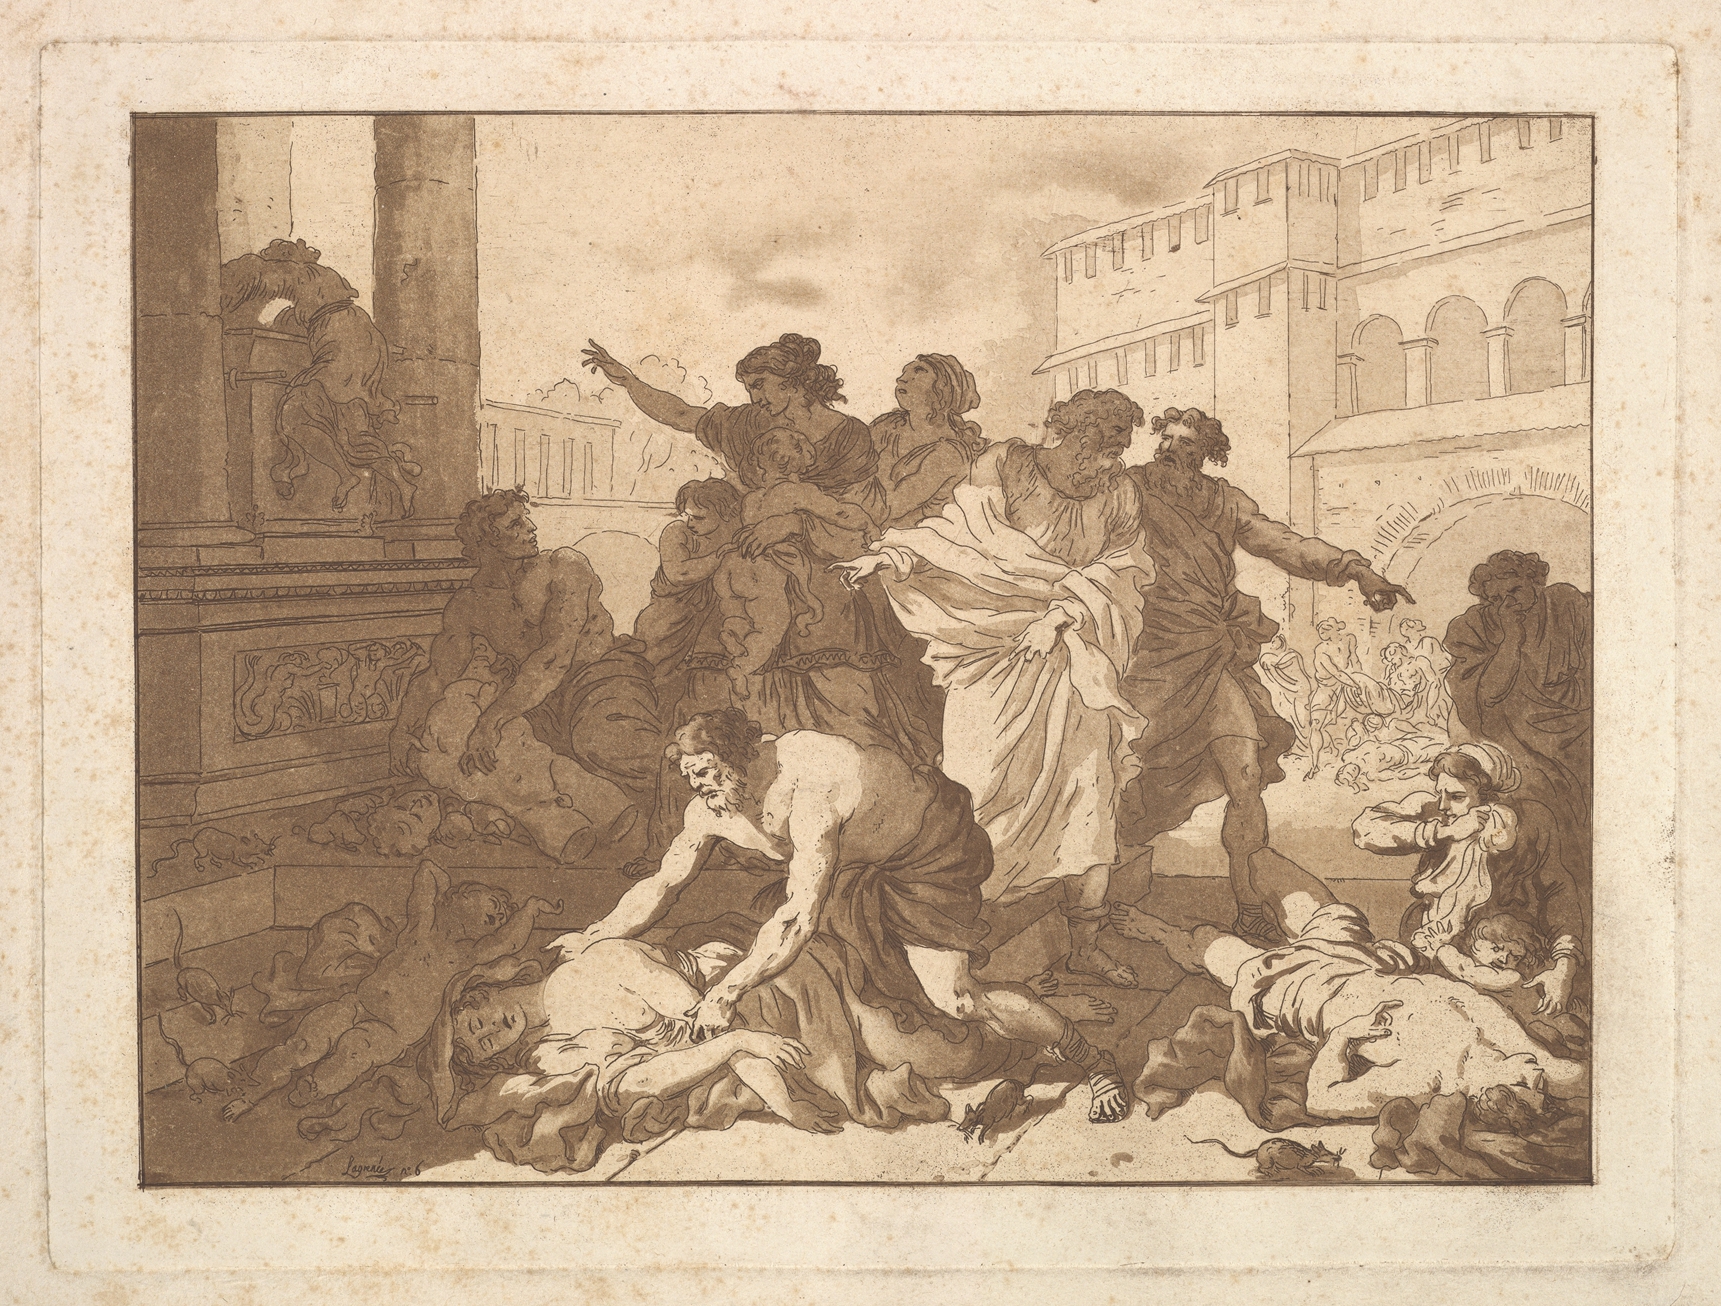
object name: print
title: La Peste chez les Philistins (Plague Among the Philistines), in an album containing Recueil de Compositions par Lagrenée Le Jeune (Collection of Compositions by Lagrenée the Younger)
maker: jean jacques lagrenée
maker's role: artist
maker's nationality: french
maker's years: 1739-1821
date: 1782-1821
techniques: aquatint, etching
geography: france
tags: illness,infants,men,women